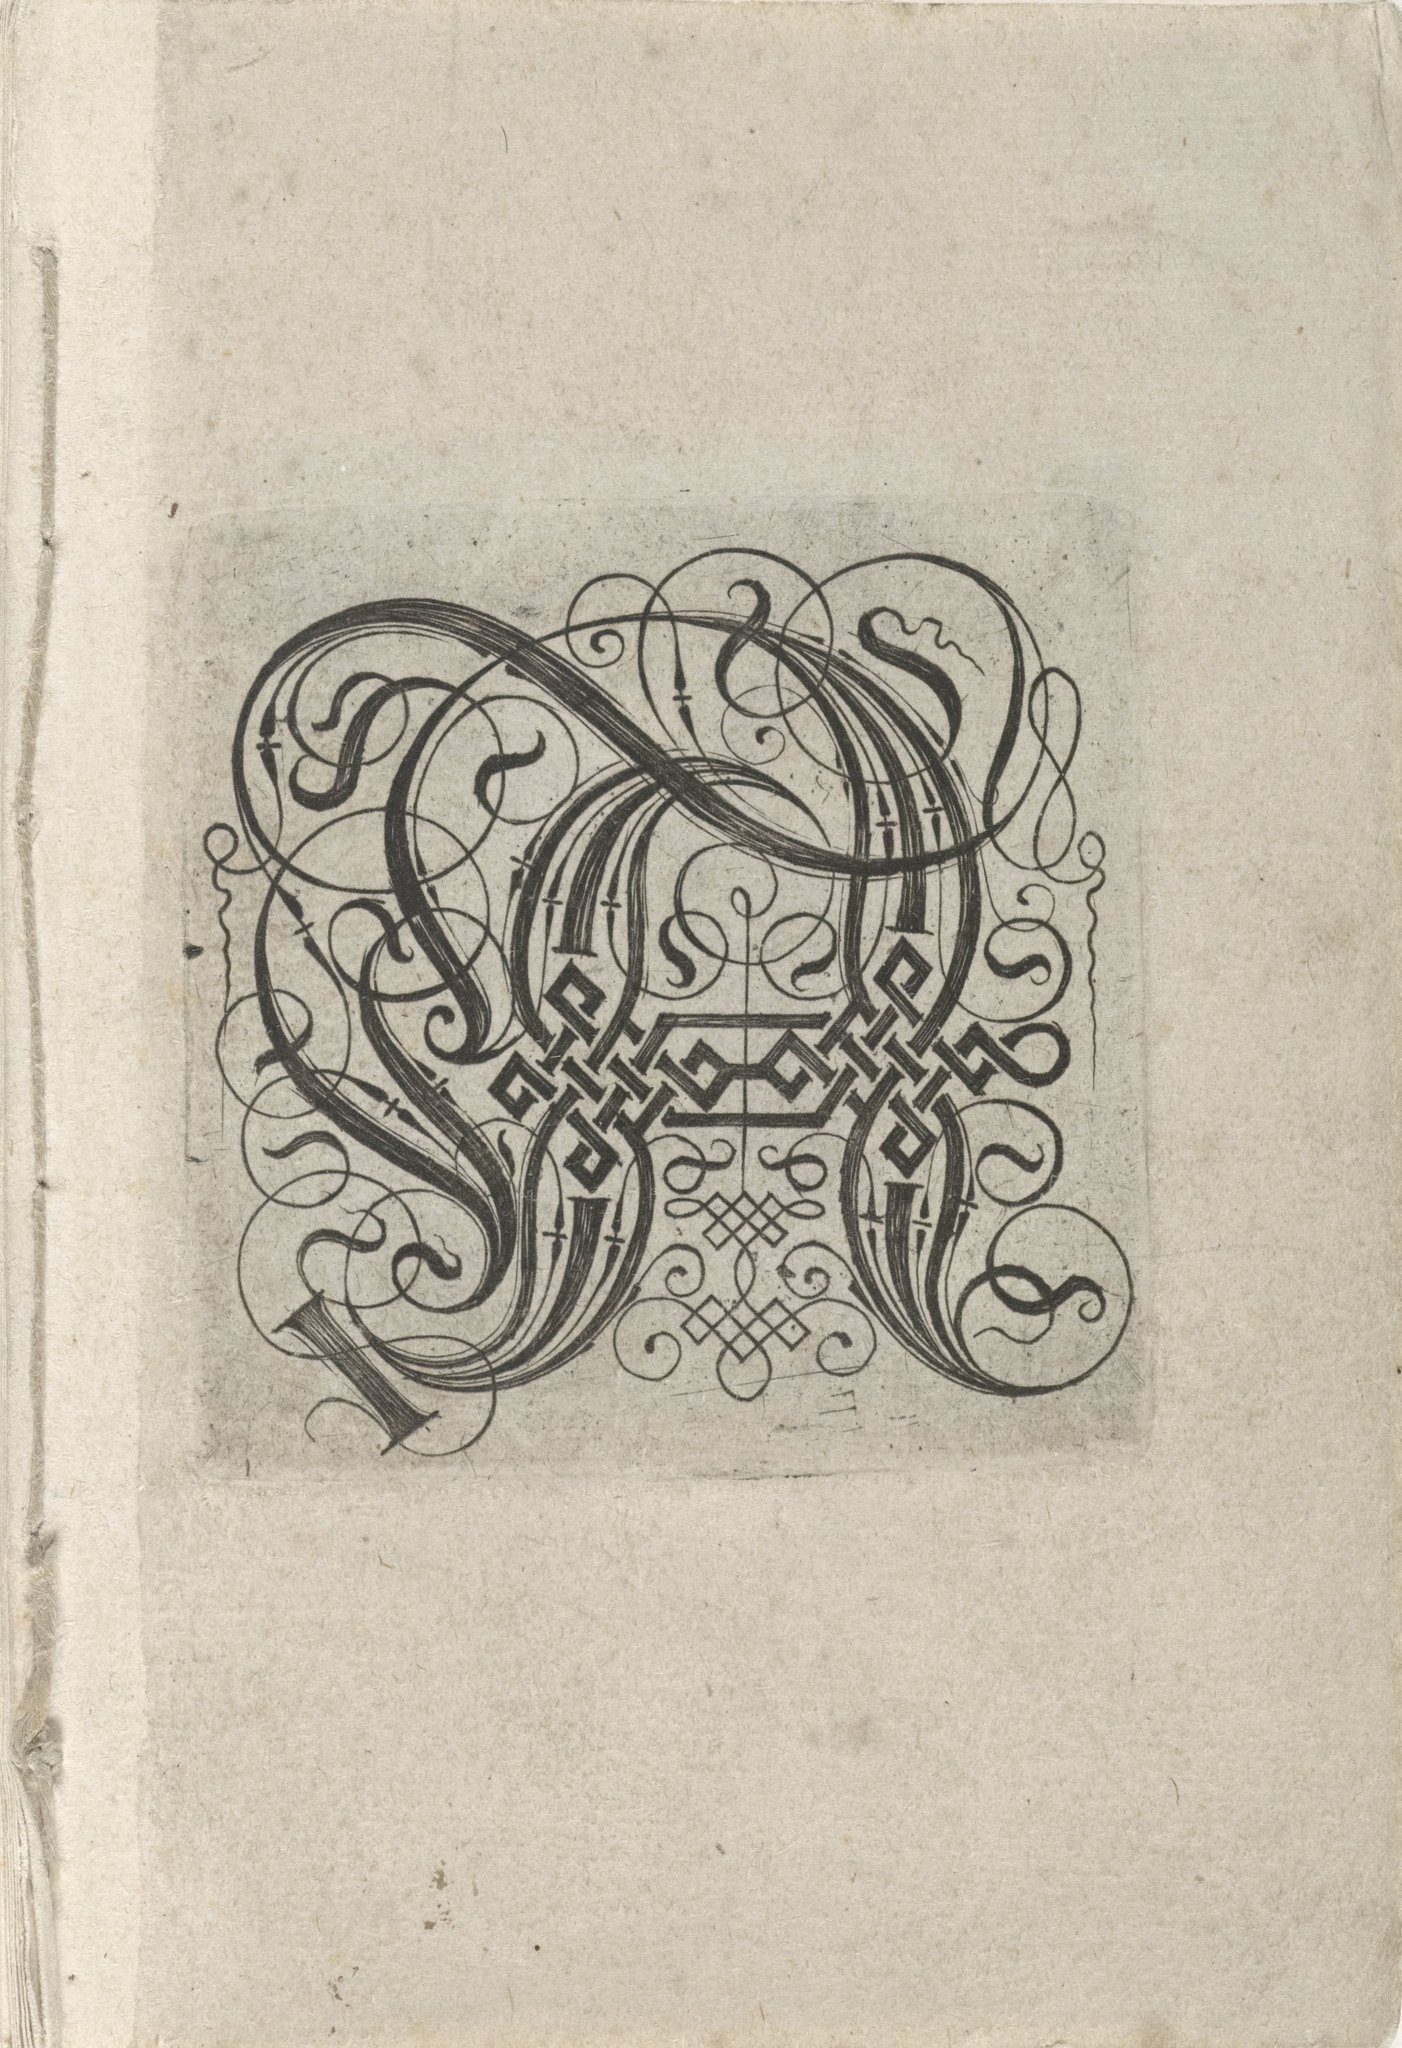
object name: print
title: Alfabet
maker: Anonymous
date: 1600-1699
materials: paper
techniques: engraving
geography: netherlands